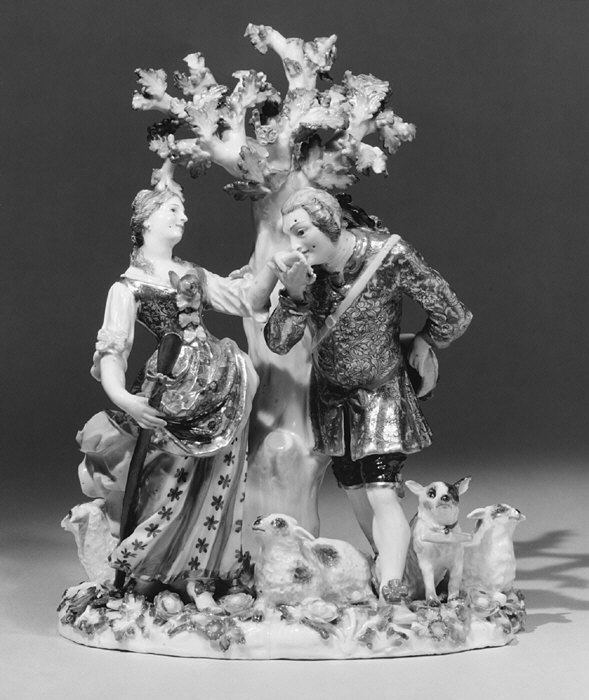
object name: group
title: Shepherd lovers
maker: meissen manufactory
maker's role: manufactory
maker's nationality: german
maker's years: 1710-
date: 1738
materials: hard paste porcelain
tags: men,lovers,women,sheep,shepherds